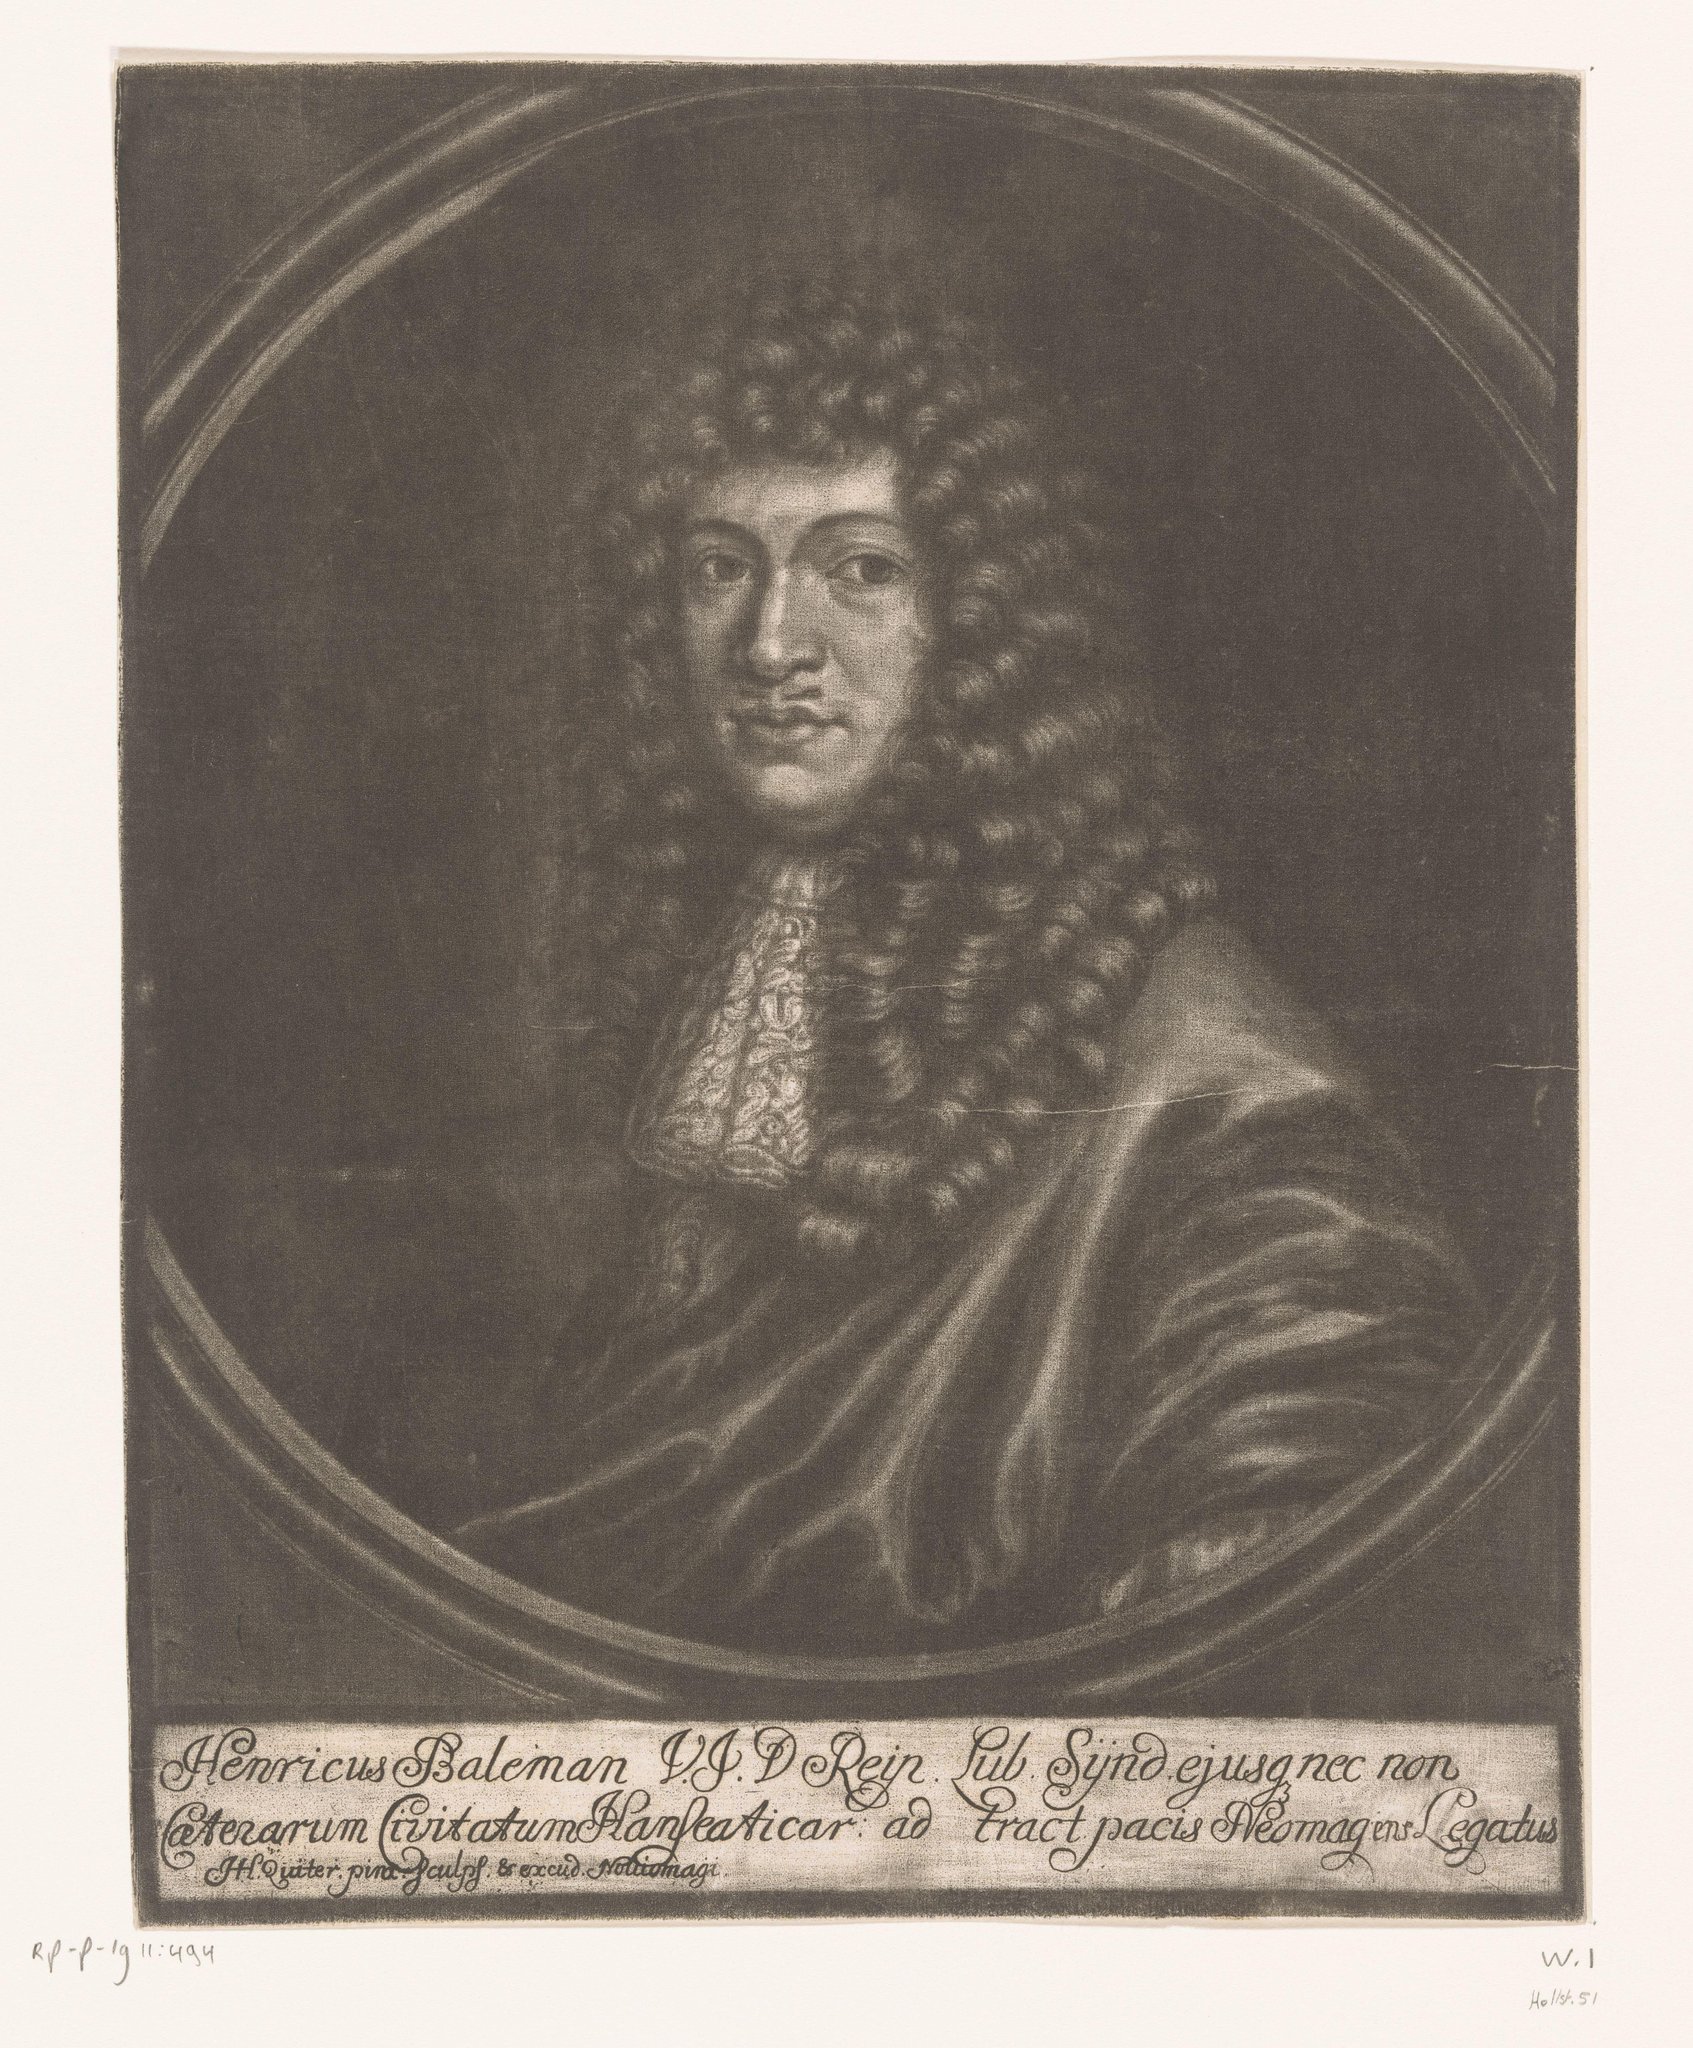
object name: print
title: Portret van Heinrich Balemann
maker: herman hendrik de quiter (i)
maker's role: painter, print maker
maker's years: 1627-1708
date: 1679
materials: paper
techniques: mezzotint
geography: nijmegen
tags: mayor, historical persons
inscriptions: collector's mark: Lugt 2228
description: Prent voor het eerst gebruikt in: Quiter, Hermann Hendrik. Icones legatorum (...). Nijmegen: s.n., 1679.